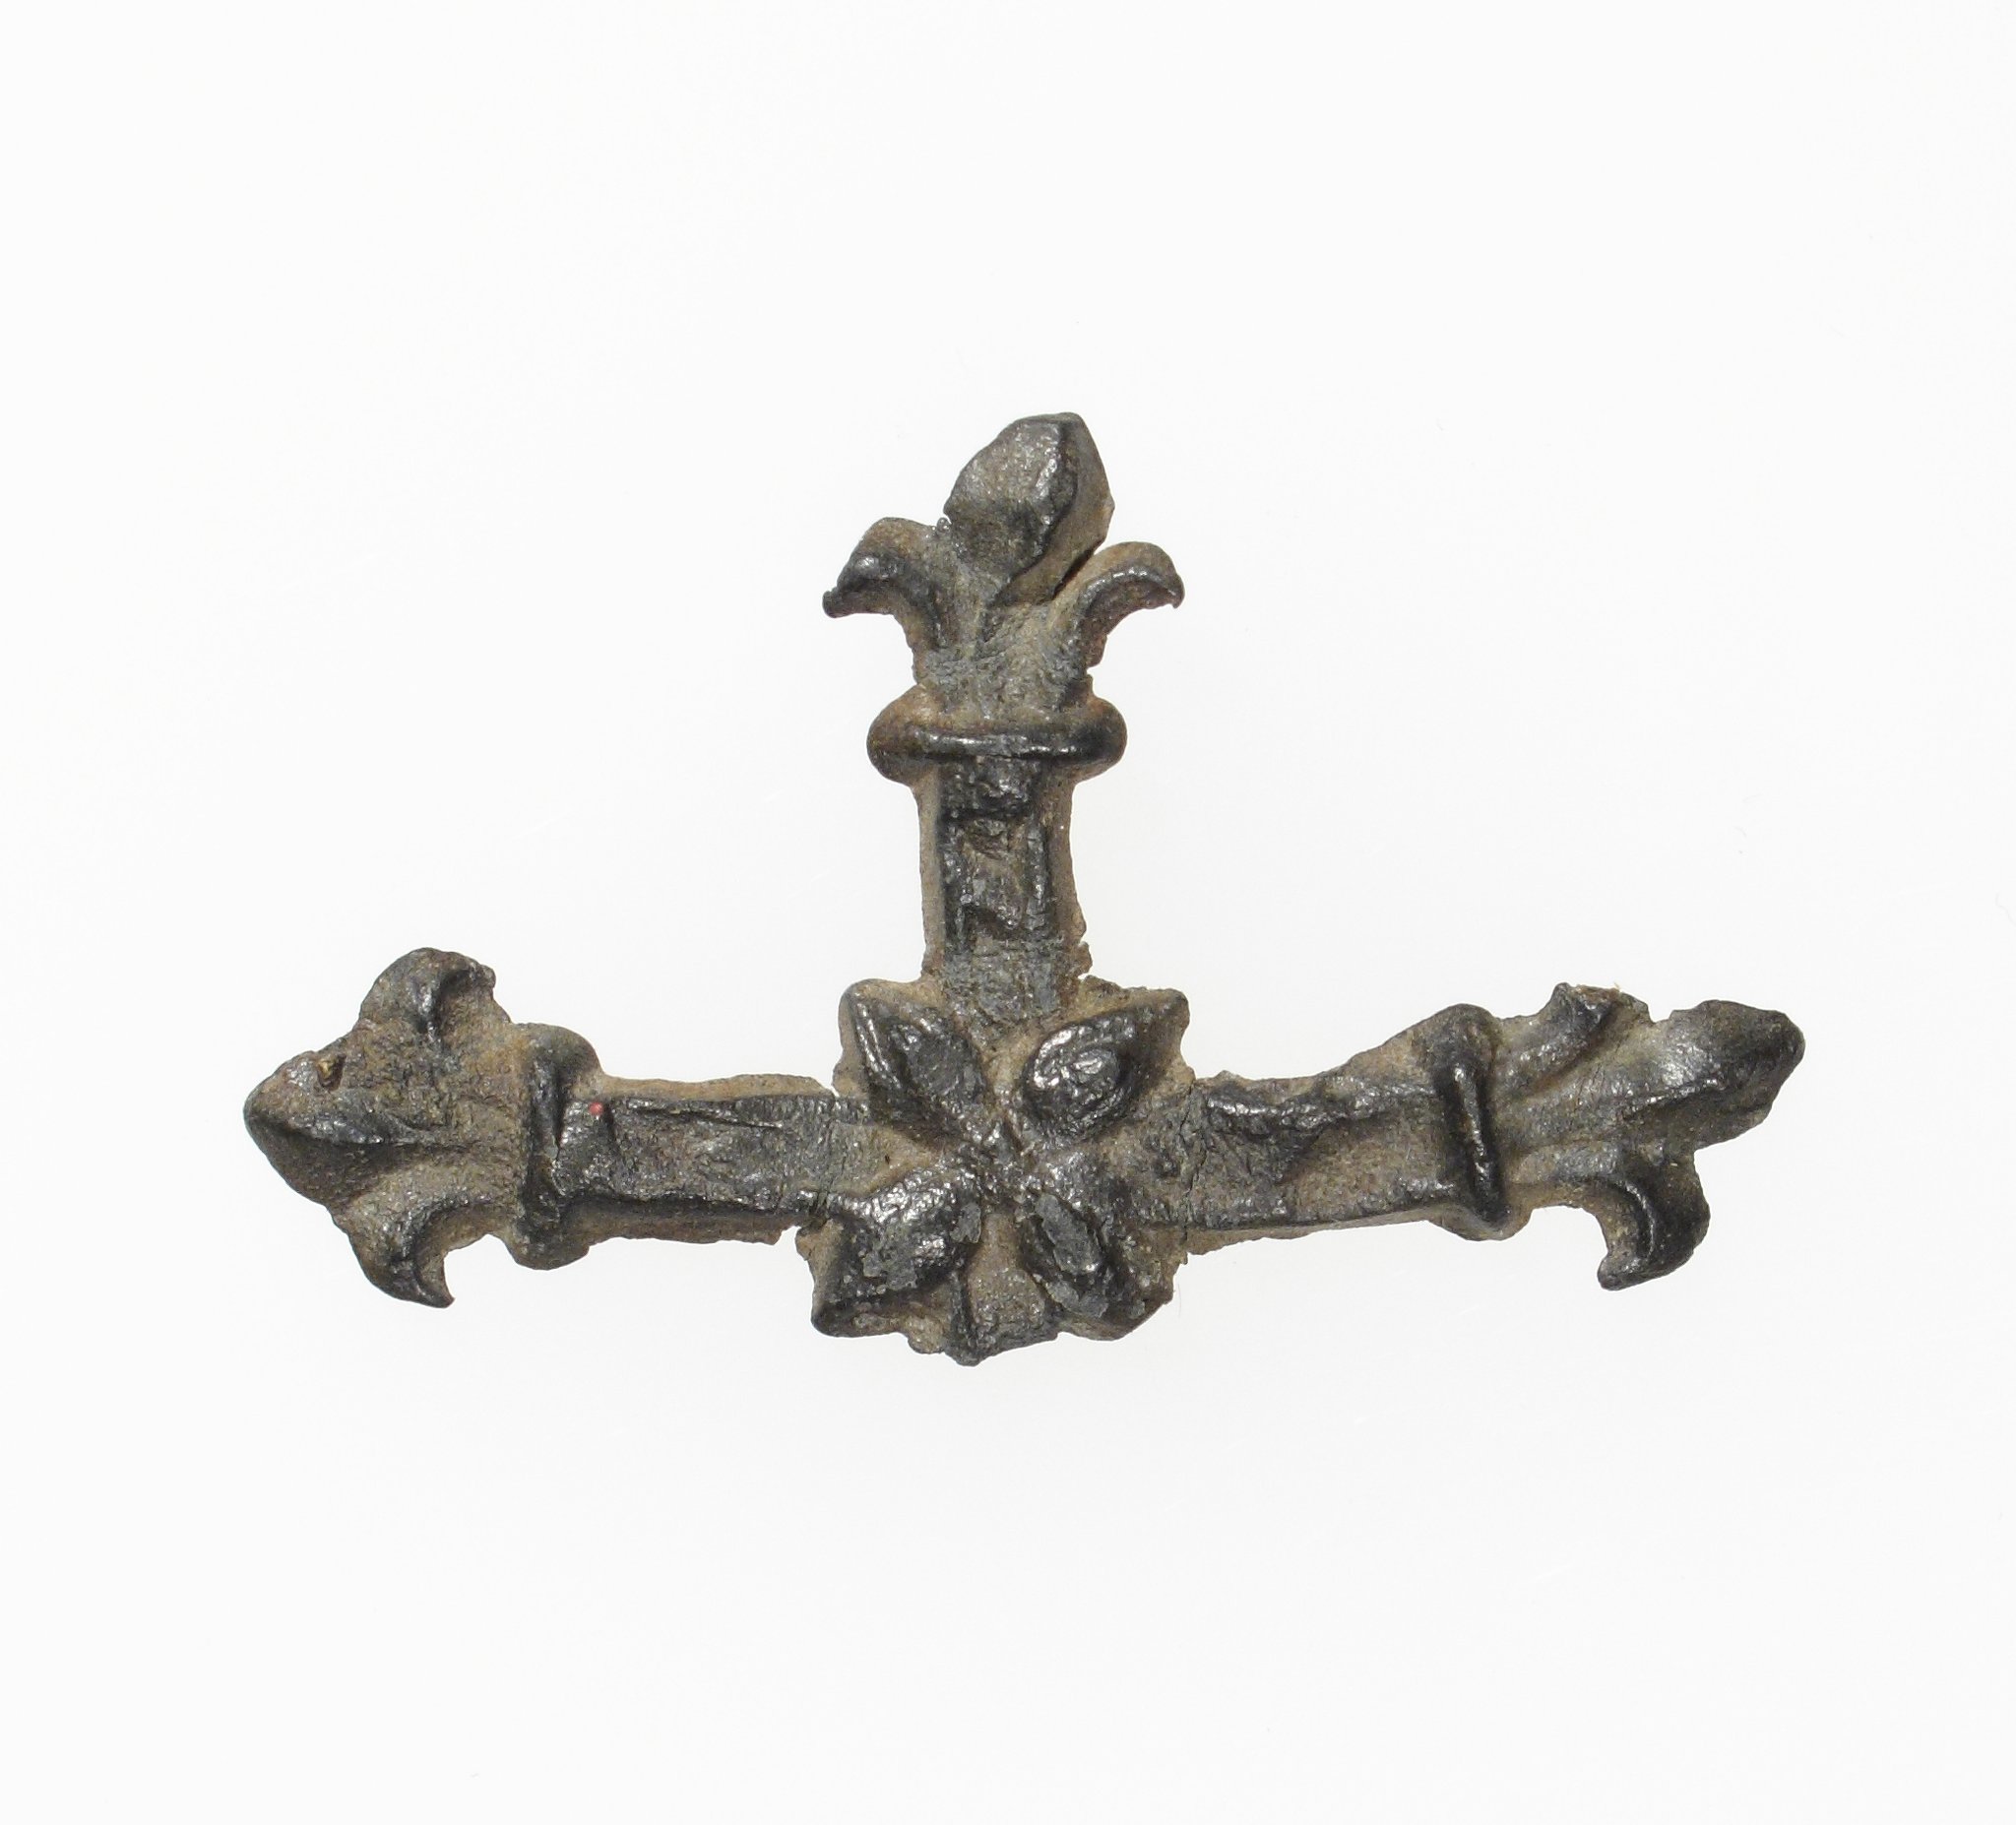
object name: pilgrim's badge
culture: french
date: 1301-1600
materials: lead